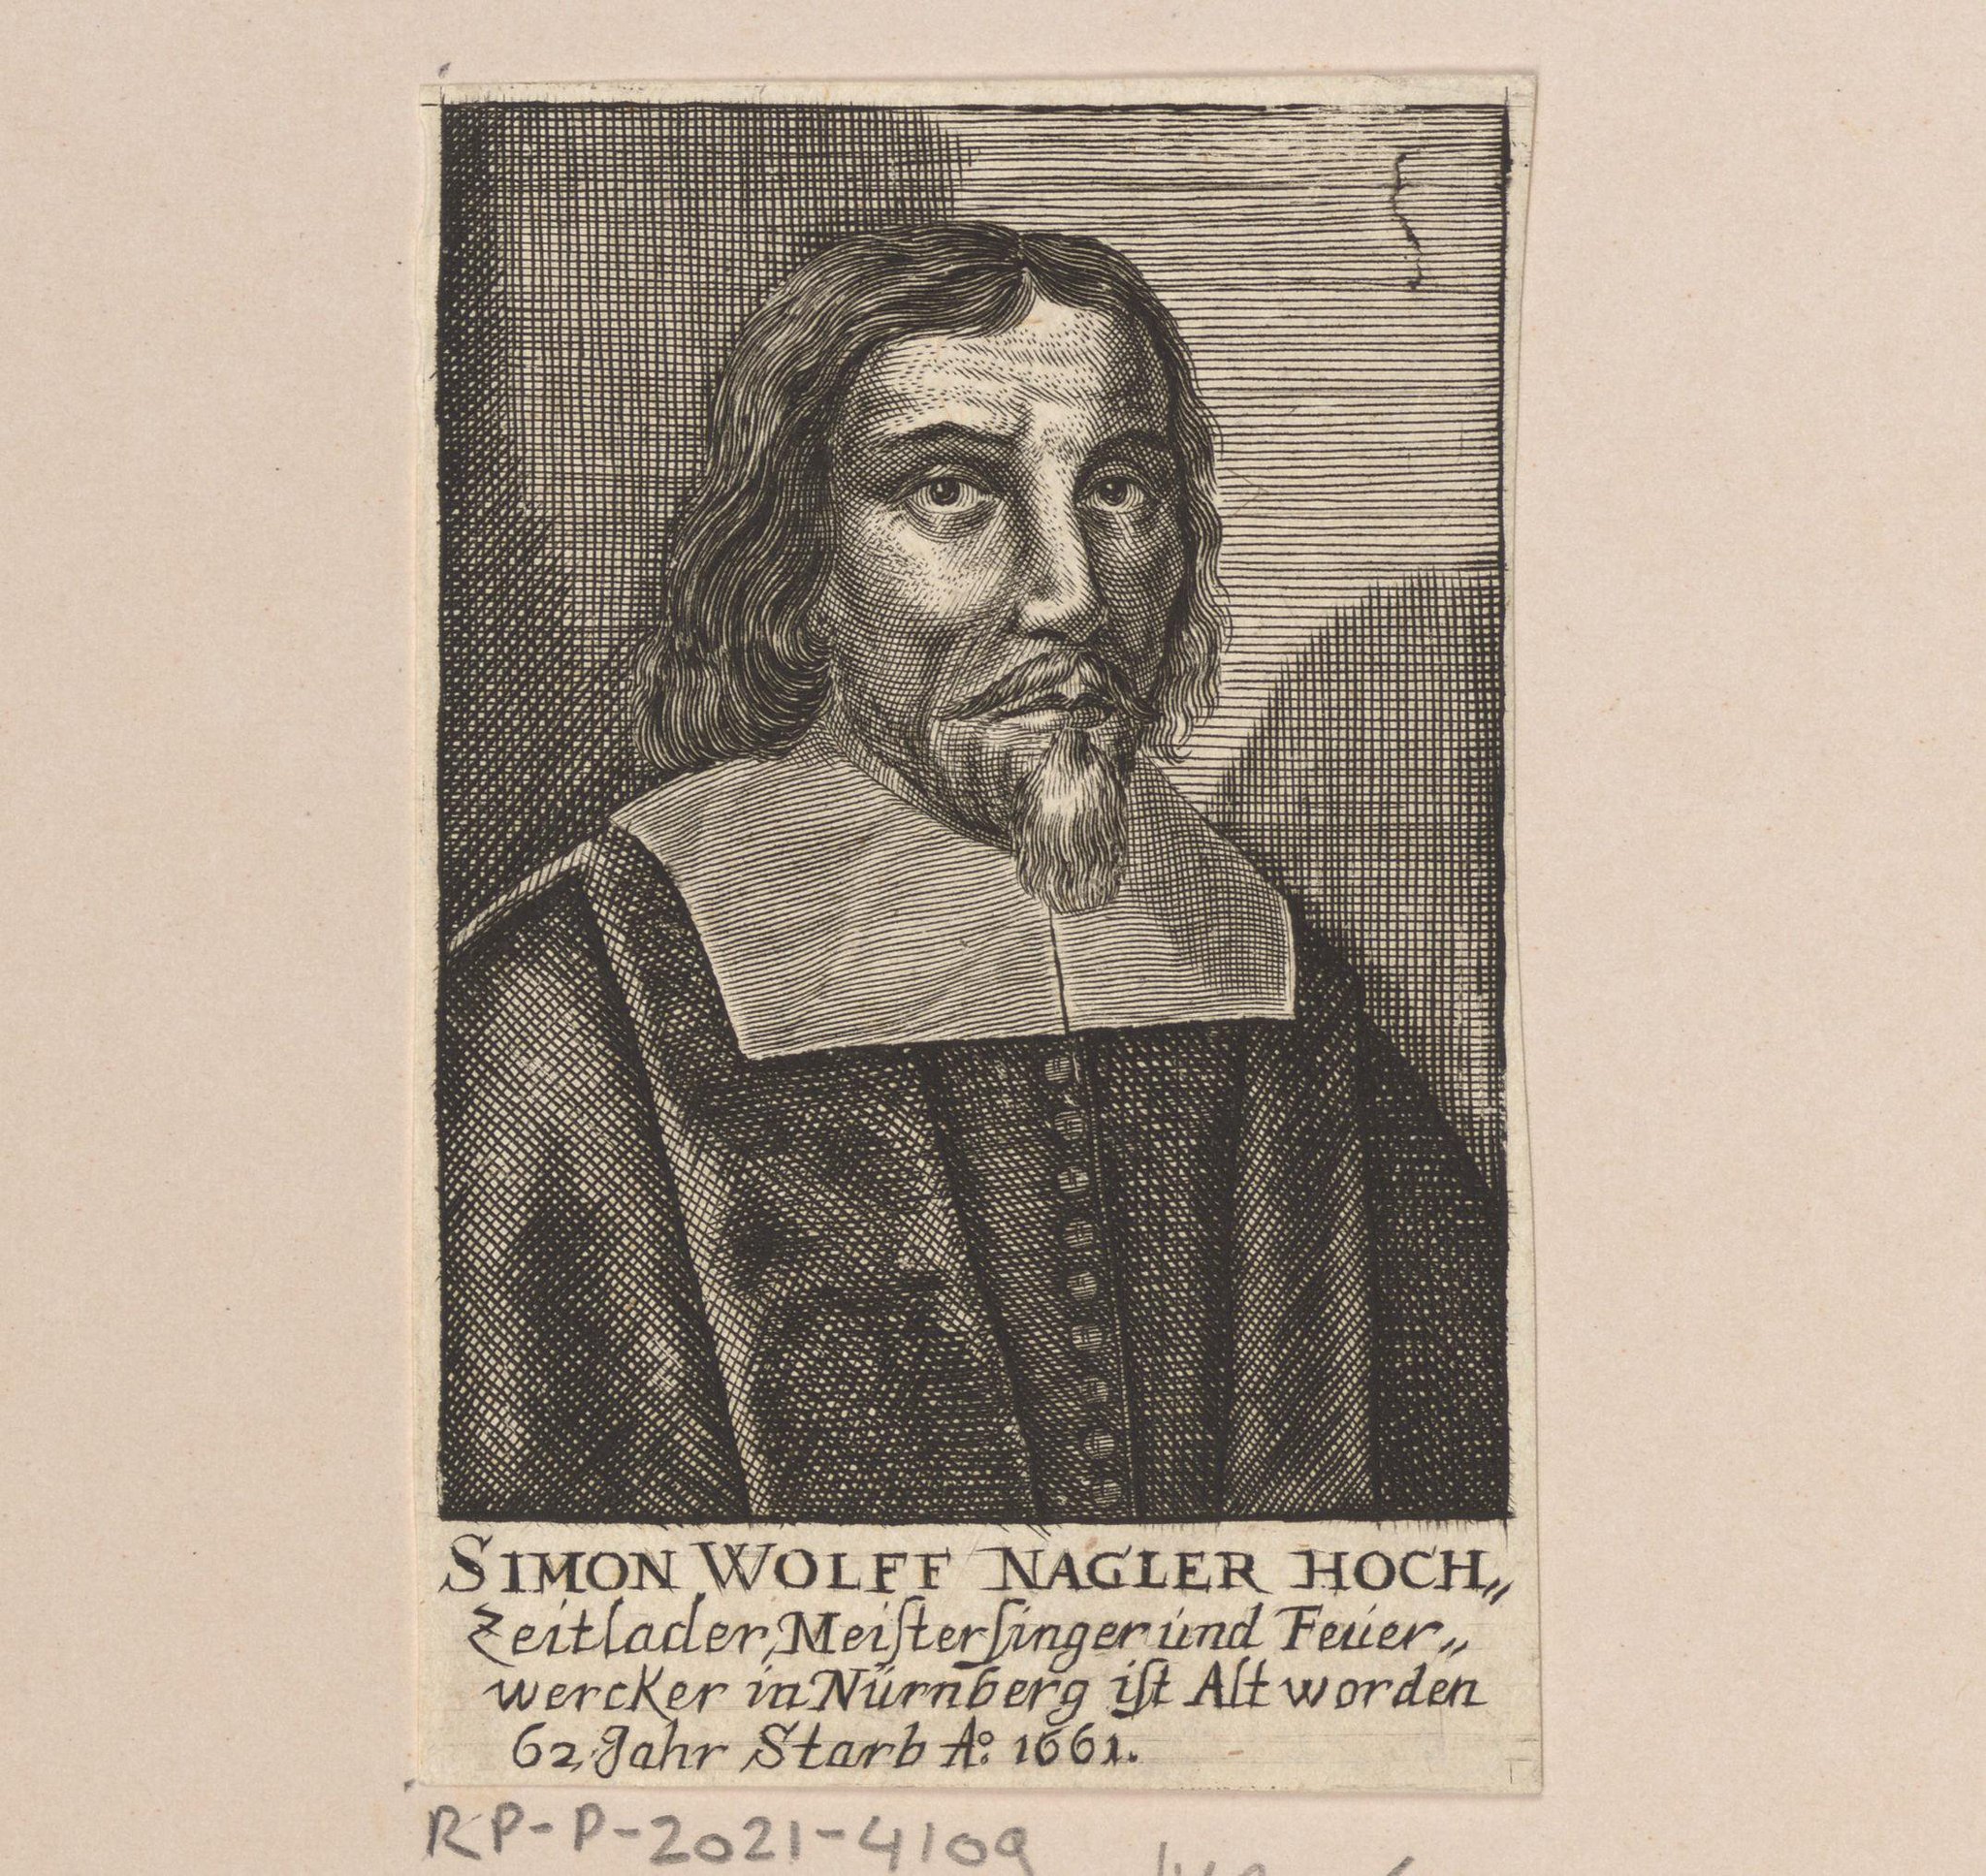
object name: print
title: Portret van Simon Wolff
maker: Anonymous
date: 1661-1749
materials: paper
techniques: engraving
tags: historical persons